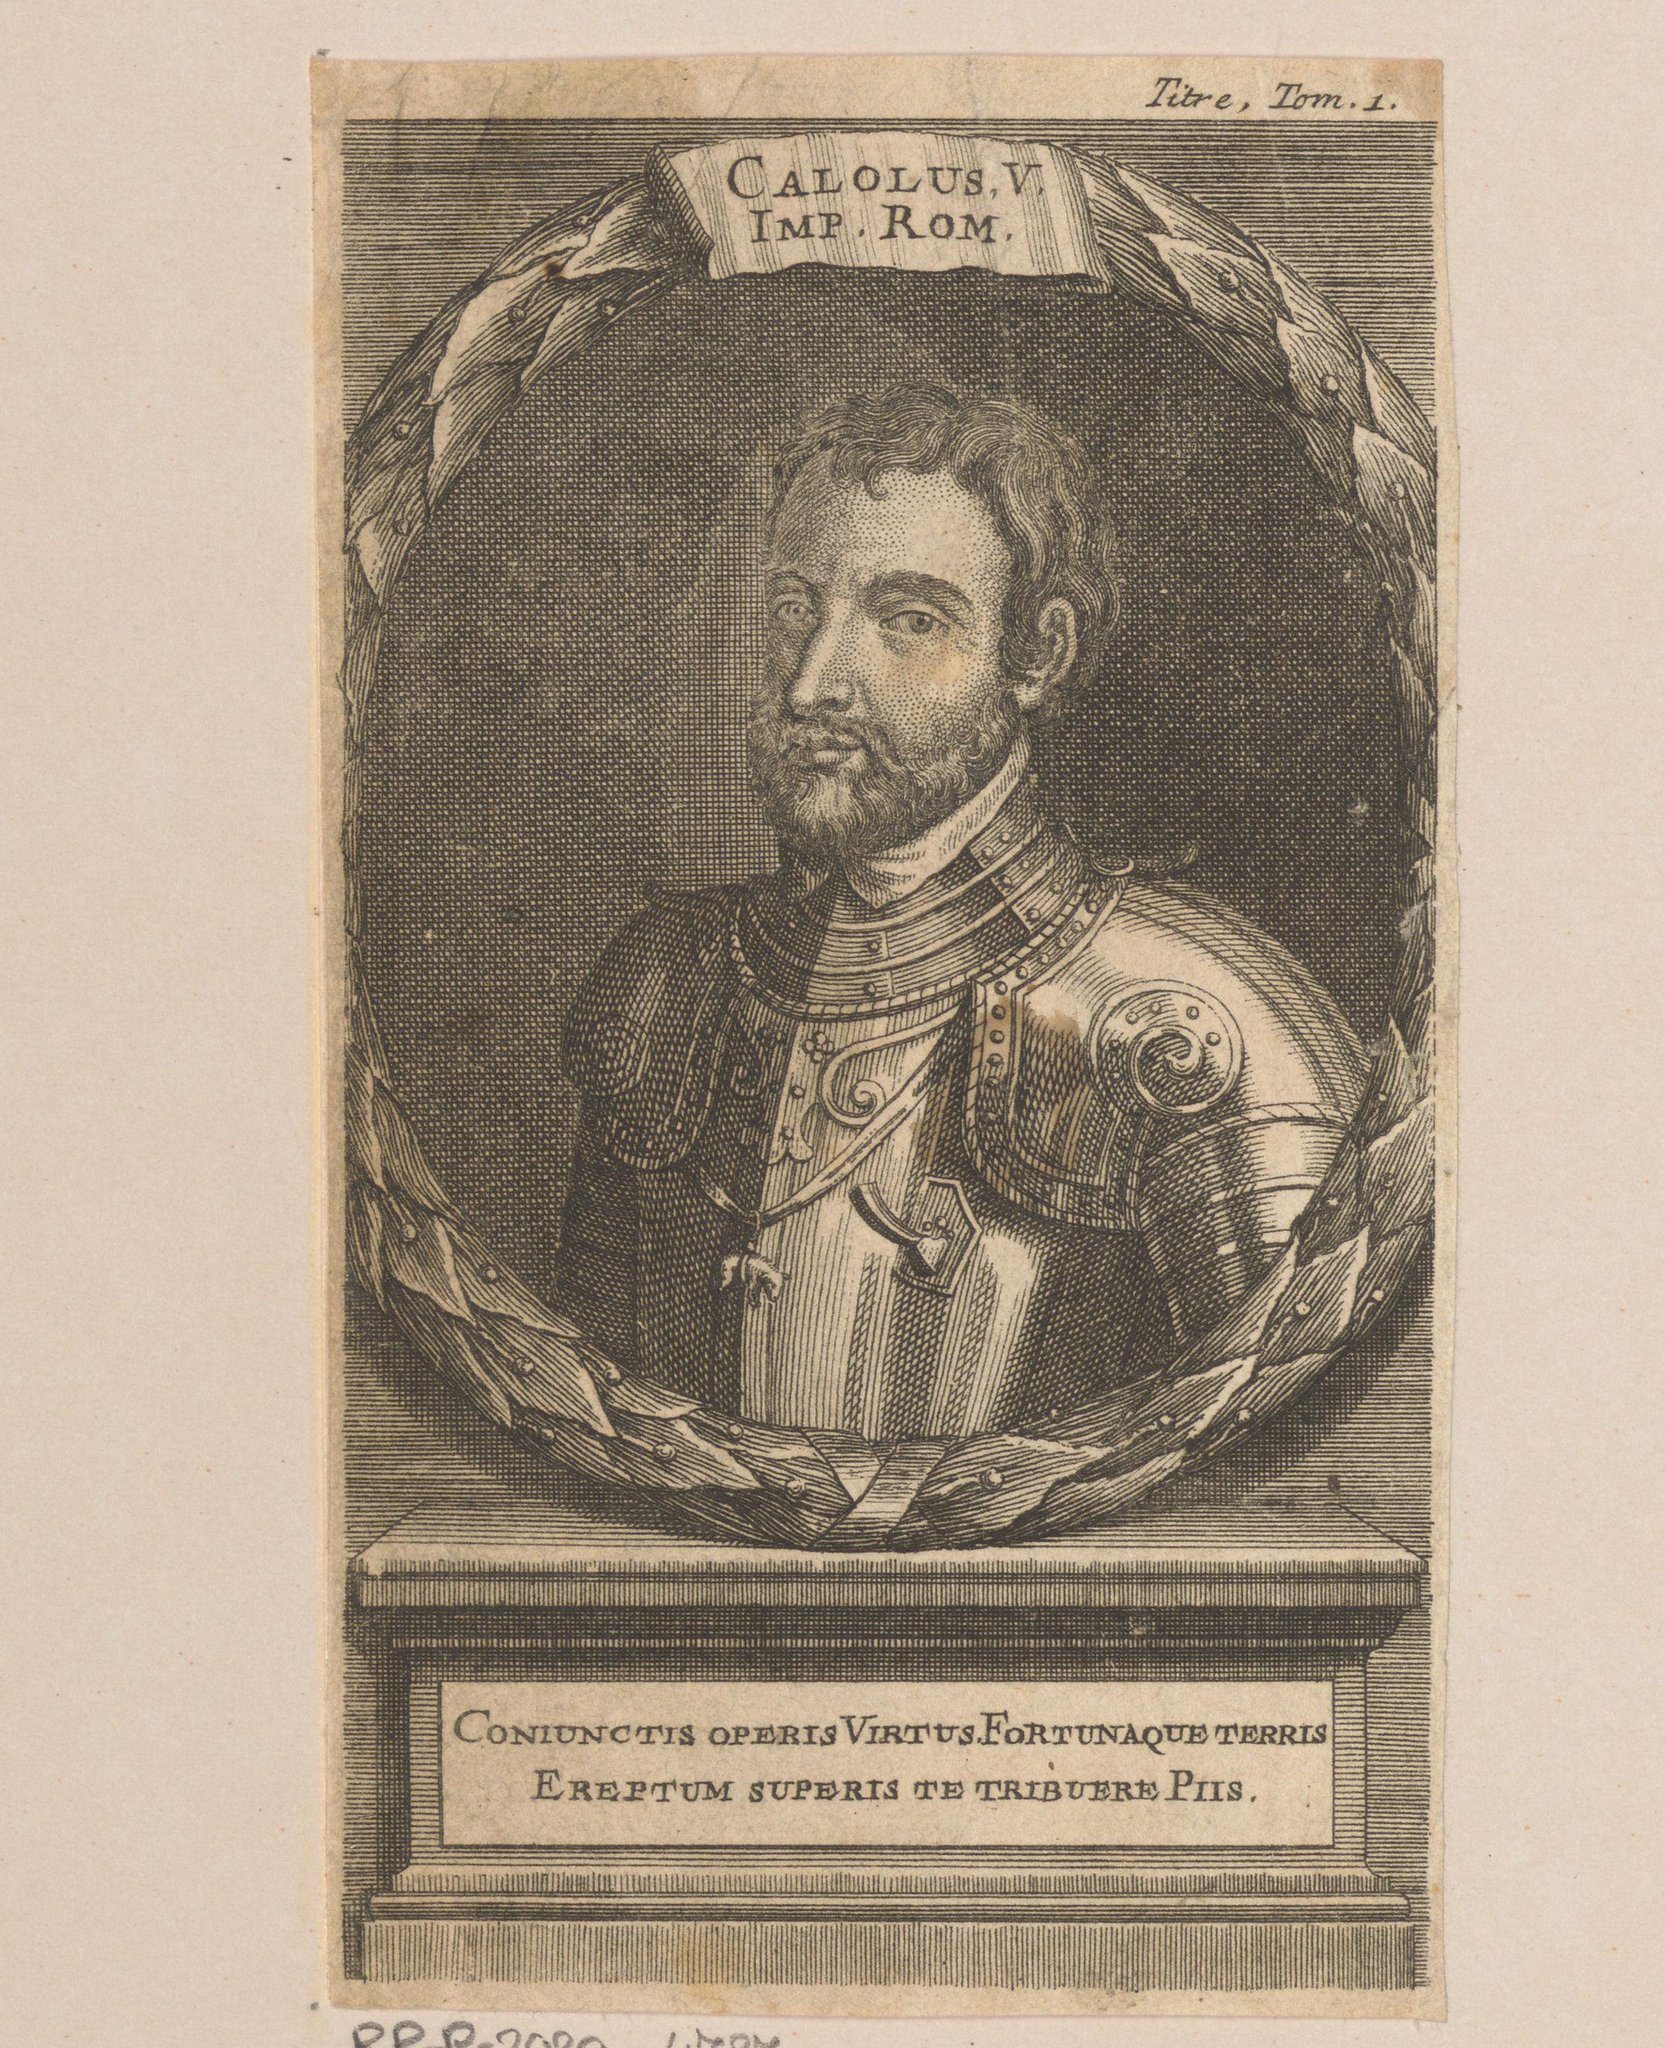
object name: print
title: Portret van keizer Karel V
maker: Anonymous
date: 1715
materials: paper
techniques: etching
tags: ghent, charles v (holy roman emperor and king of spain), historical persons, king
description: Prent mogelijk uit: La vie de l'empereur Charles V. Brussel: Josse de Grieck, 1715, dl. 1.